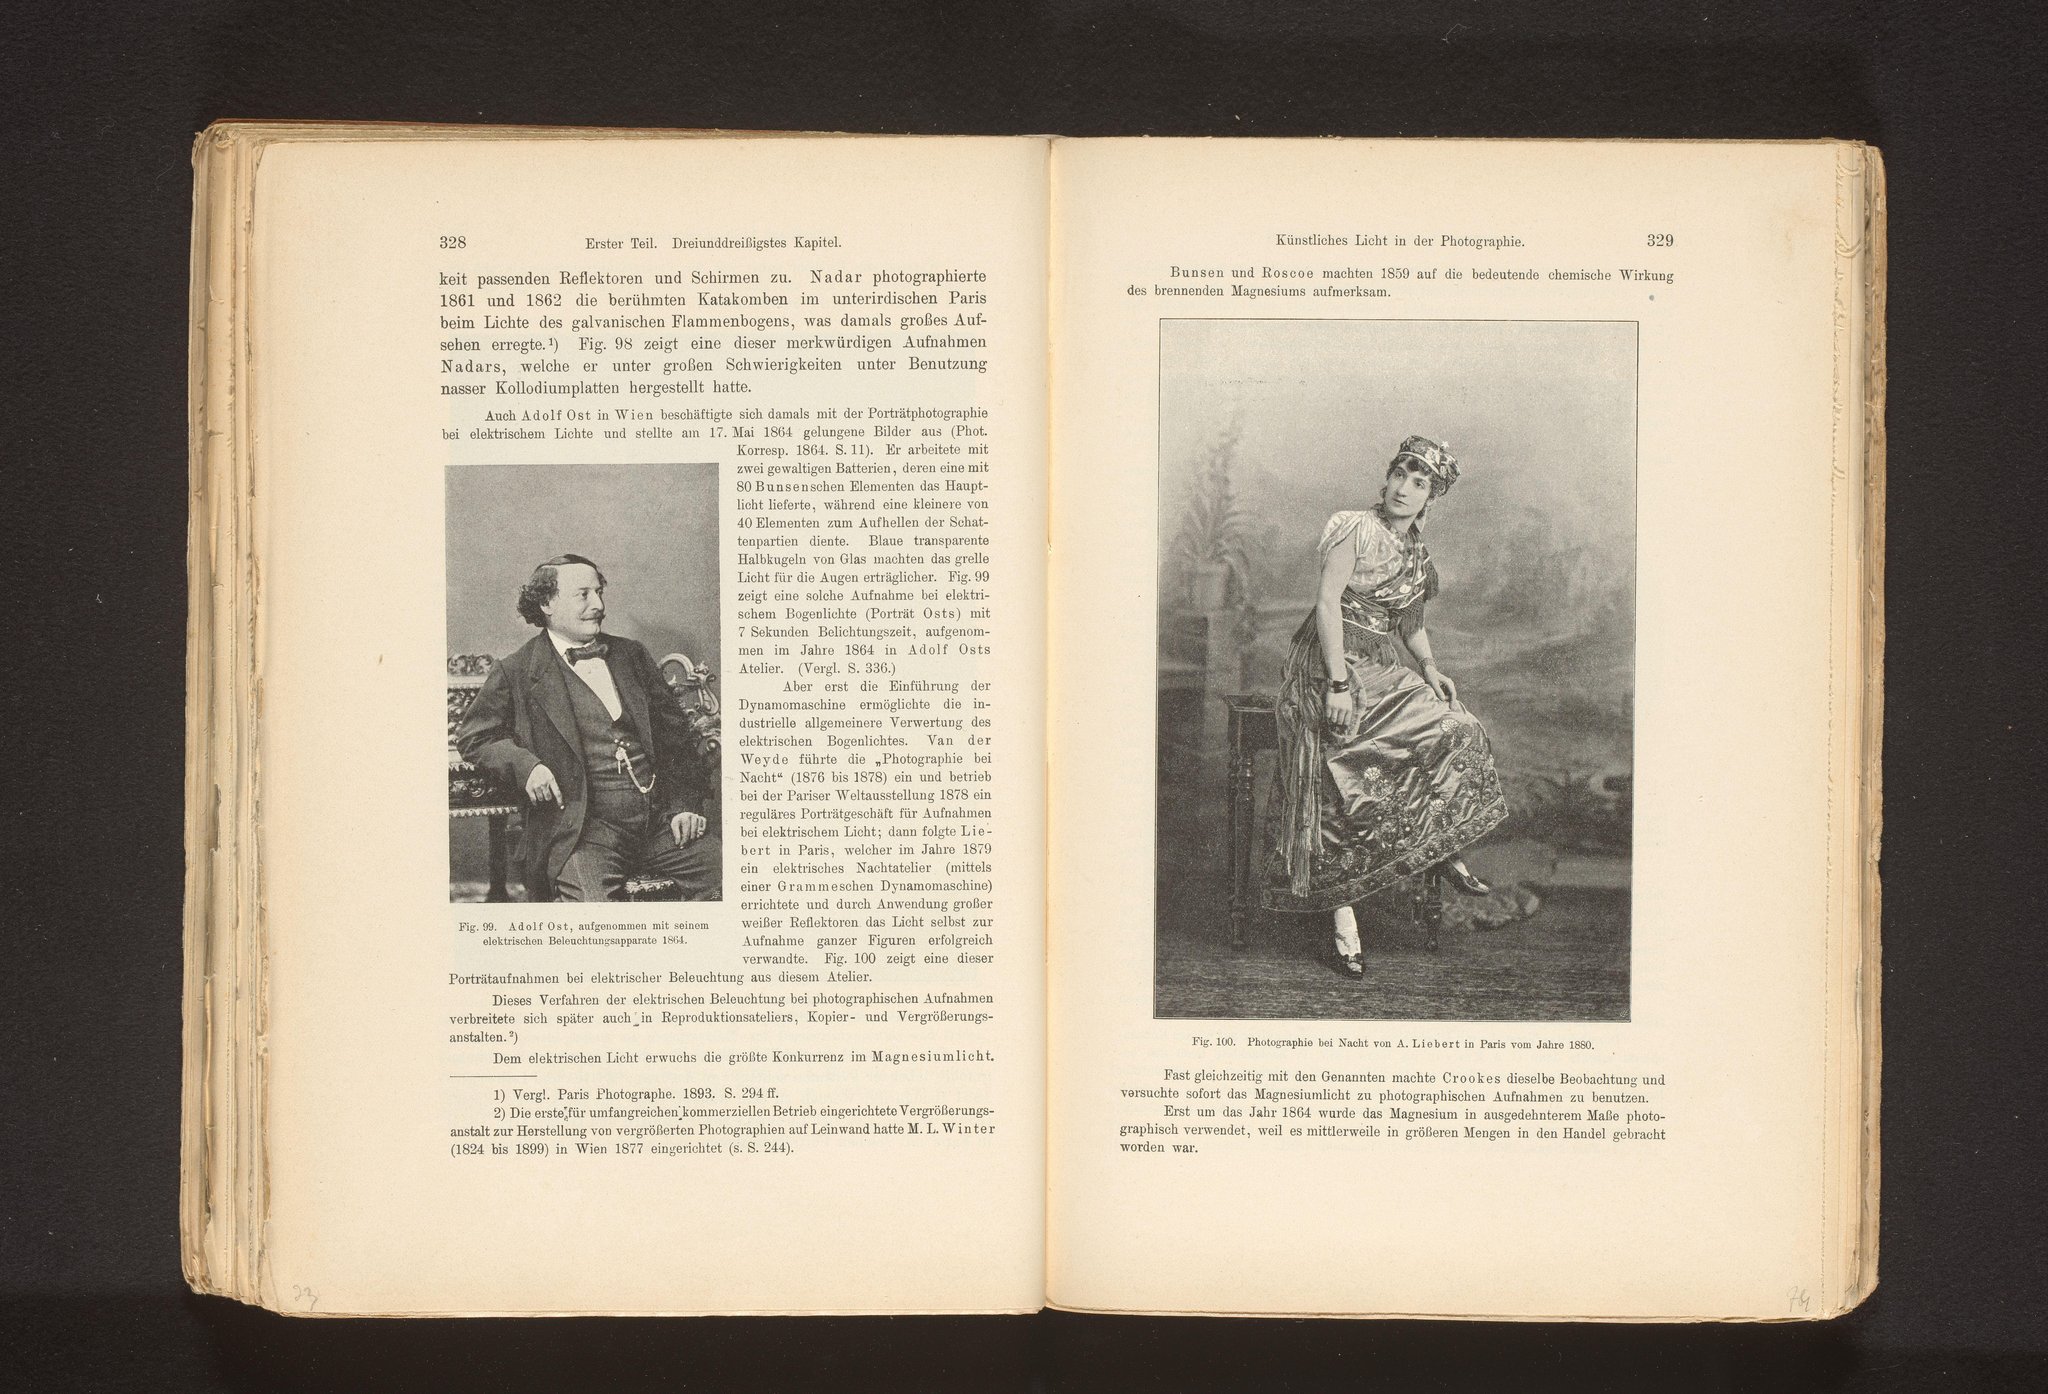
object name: photomechanical print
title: Studioportret van een onbekende vrouw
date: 1900-1905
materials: paper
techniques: autotype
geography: paris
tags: studio ~ photographer, adult woman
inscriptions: number: ‘Fig. 100.’